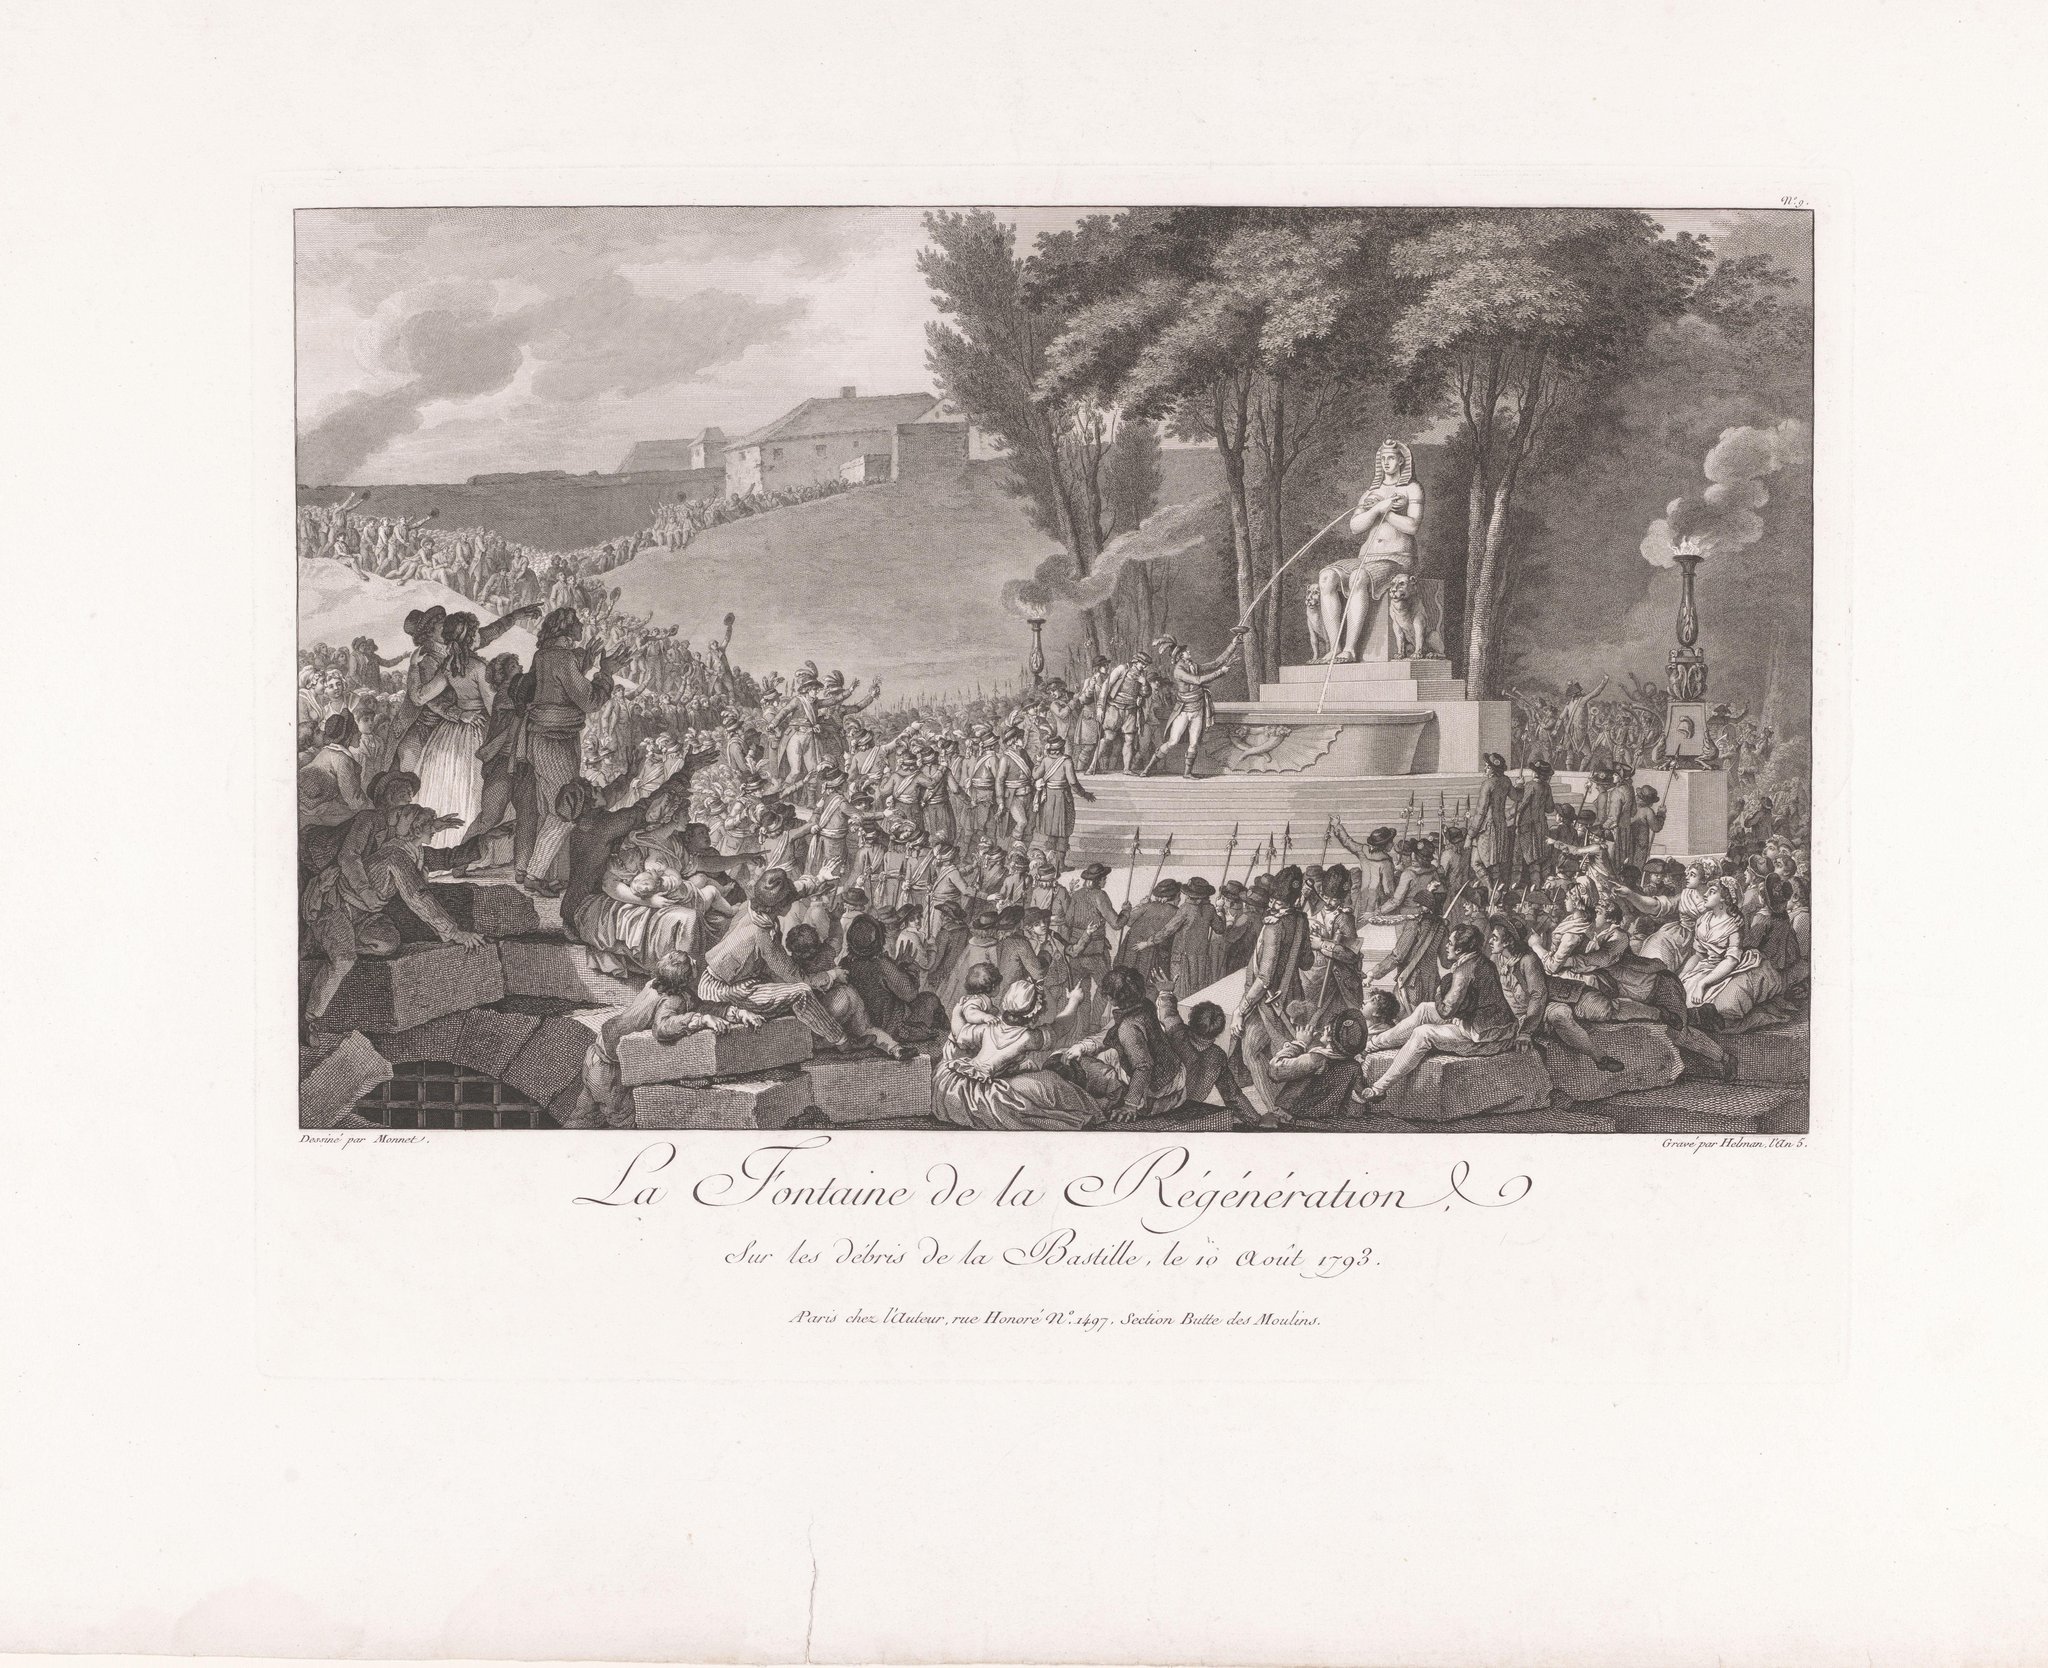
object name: print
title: Jubileum van de bestorming van de Tuilerieën met mogelijk Marie-Jean Hérault de Séchelles bij de Fontaine de la Régénération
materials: paper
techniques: engraving, etching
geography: paris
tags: paris, politician, historical persons, ornamental fountain, commemoration, jubilee, isis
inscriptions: collector's mark: Lugt 2228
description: Maakt deel uit van een serie getiteld 'La Révolution française depuis l'ouverture des États géneraux jusquáu 9 Brumaire' met vijftien prenten naar schilderijen met als onderwerp de eerste dagen van de Franse Revolutie. De serie werd verschillende malen uitgegeven, aanvankelijk onder de titel 'Les principales journées de la Révolution'. Voor meer informatie zie IFF 18e siècle, dl. 11, p. 291.